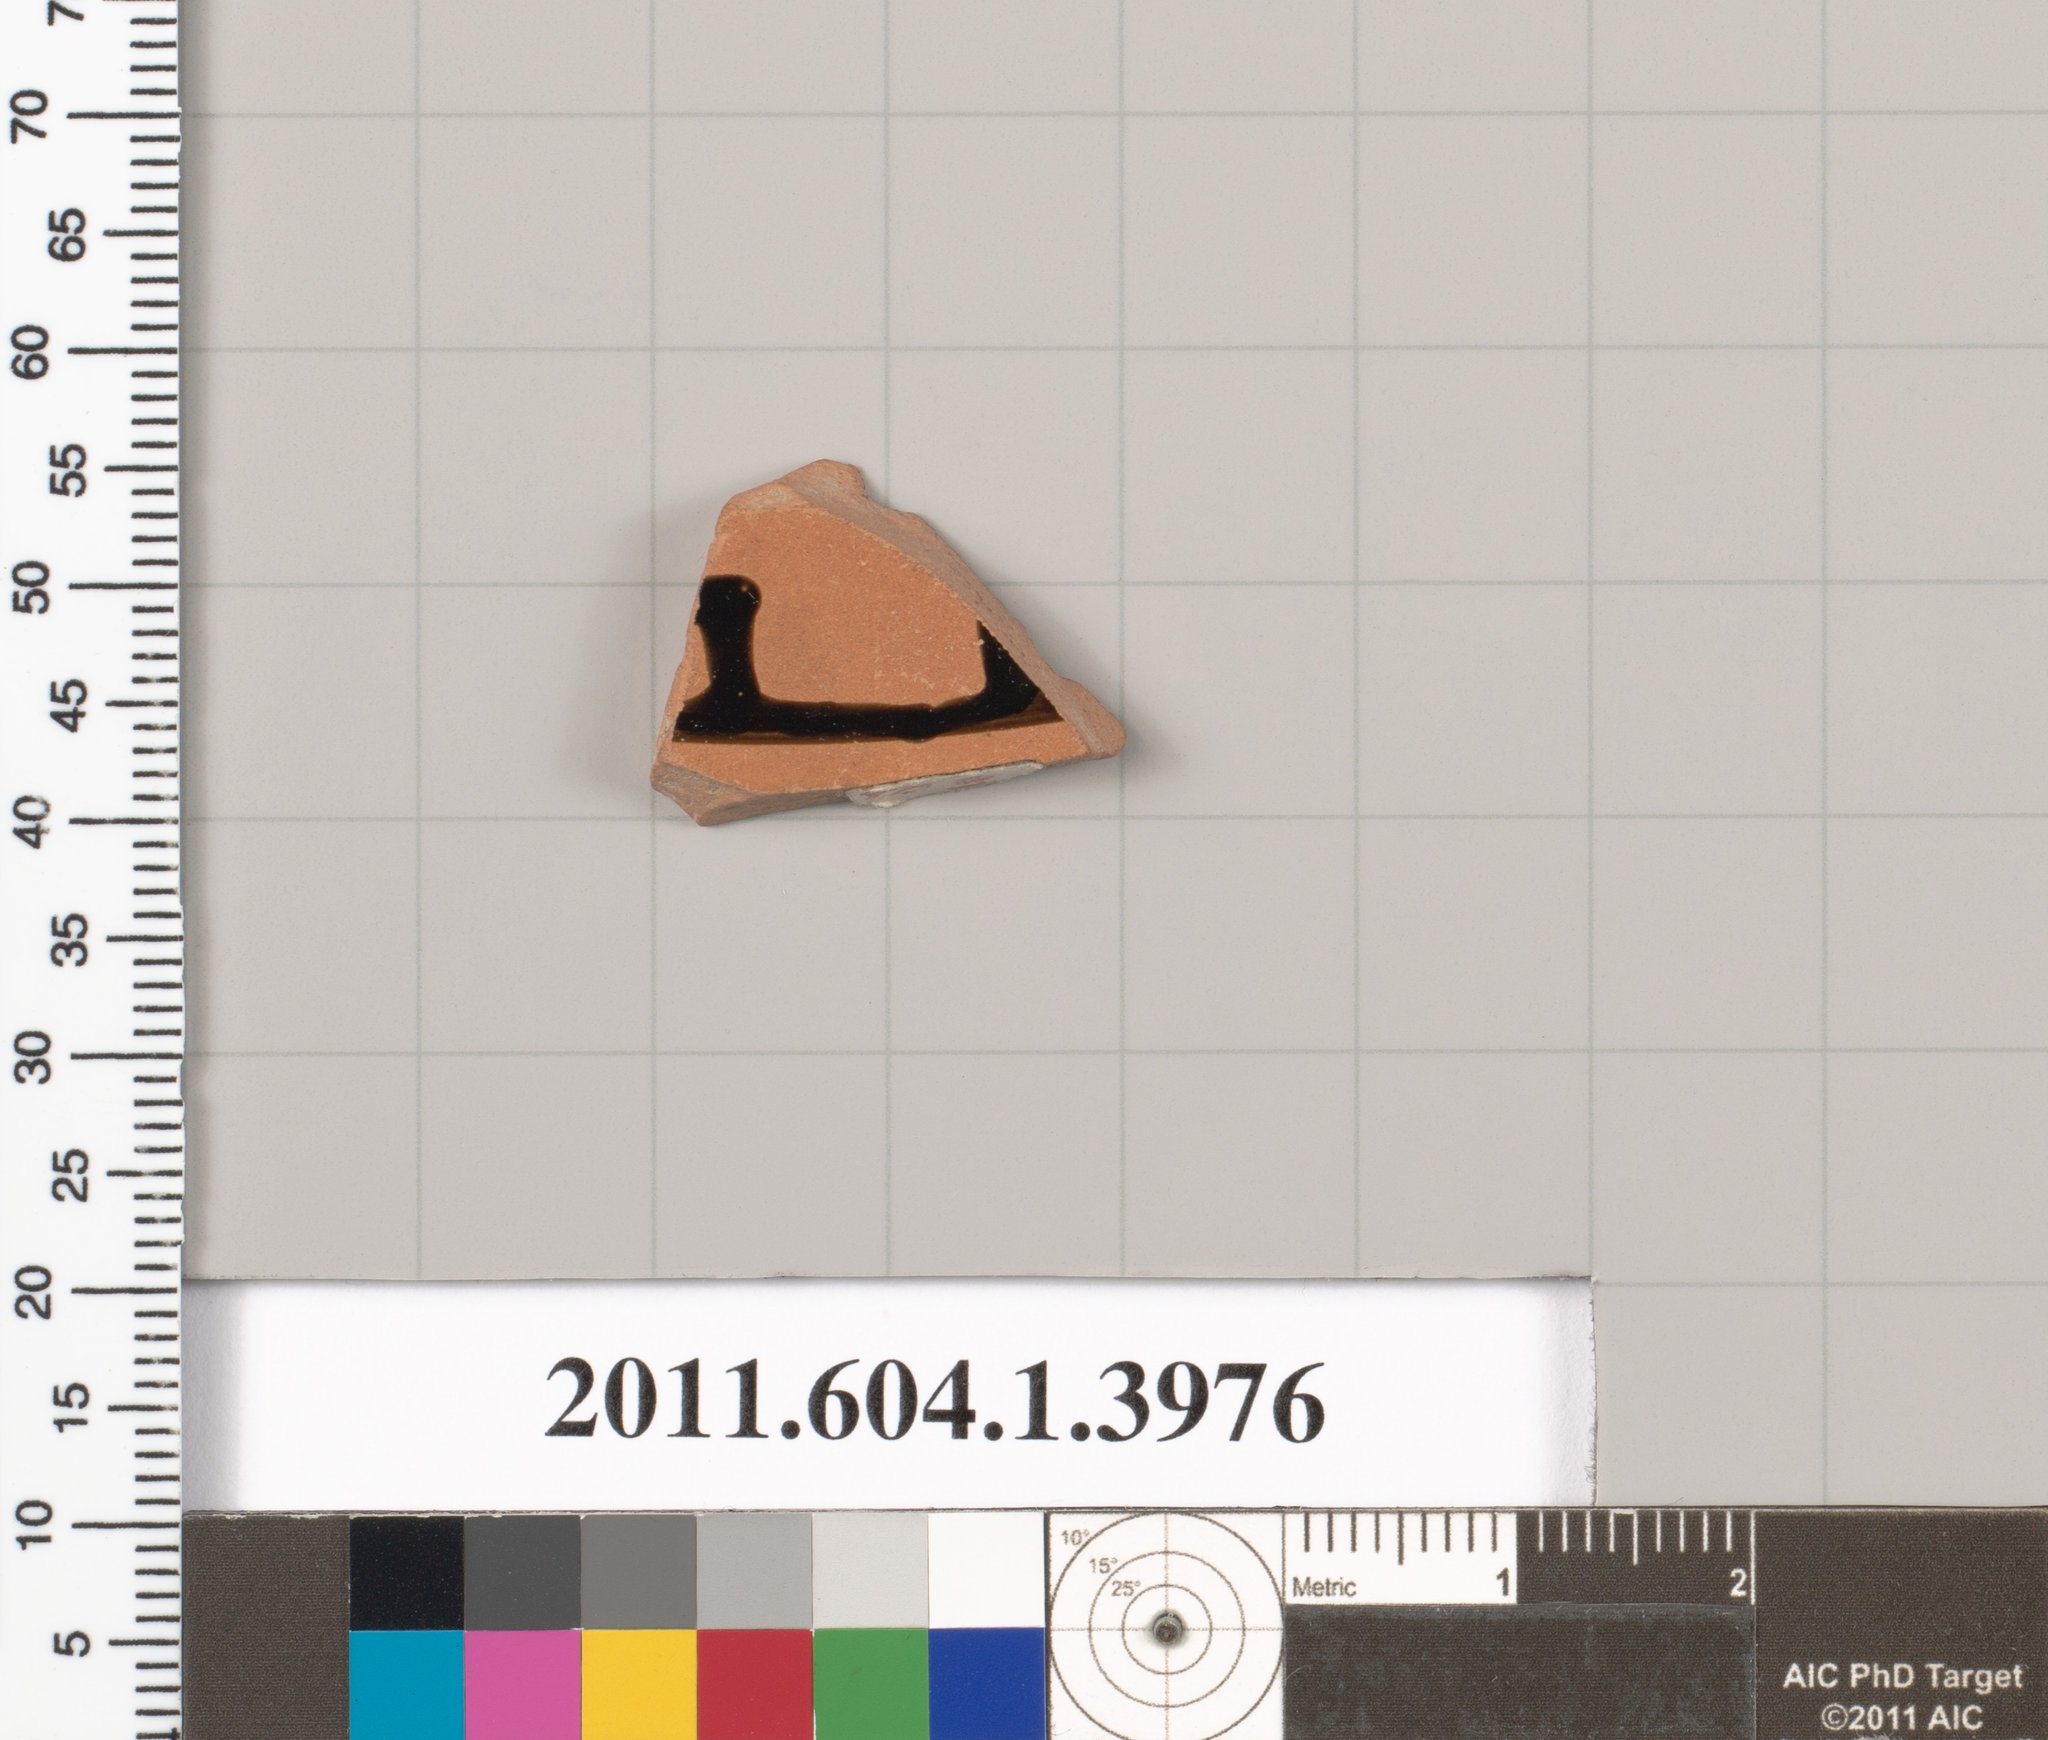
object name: kylix fragment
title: Terracotta fragment of a kylix (drinking cup)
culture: greek, attic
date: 500-480 BCE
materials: terracotta